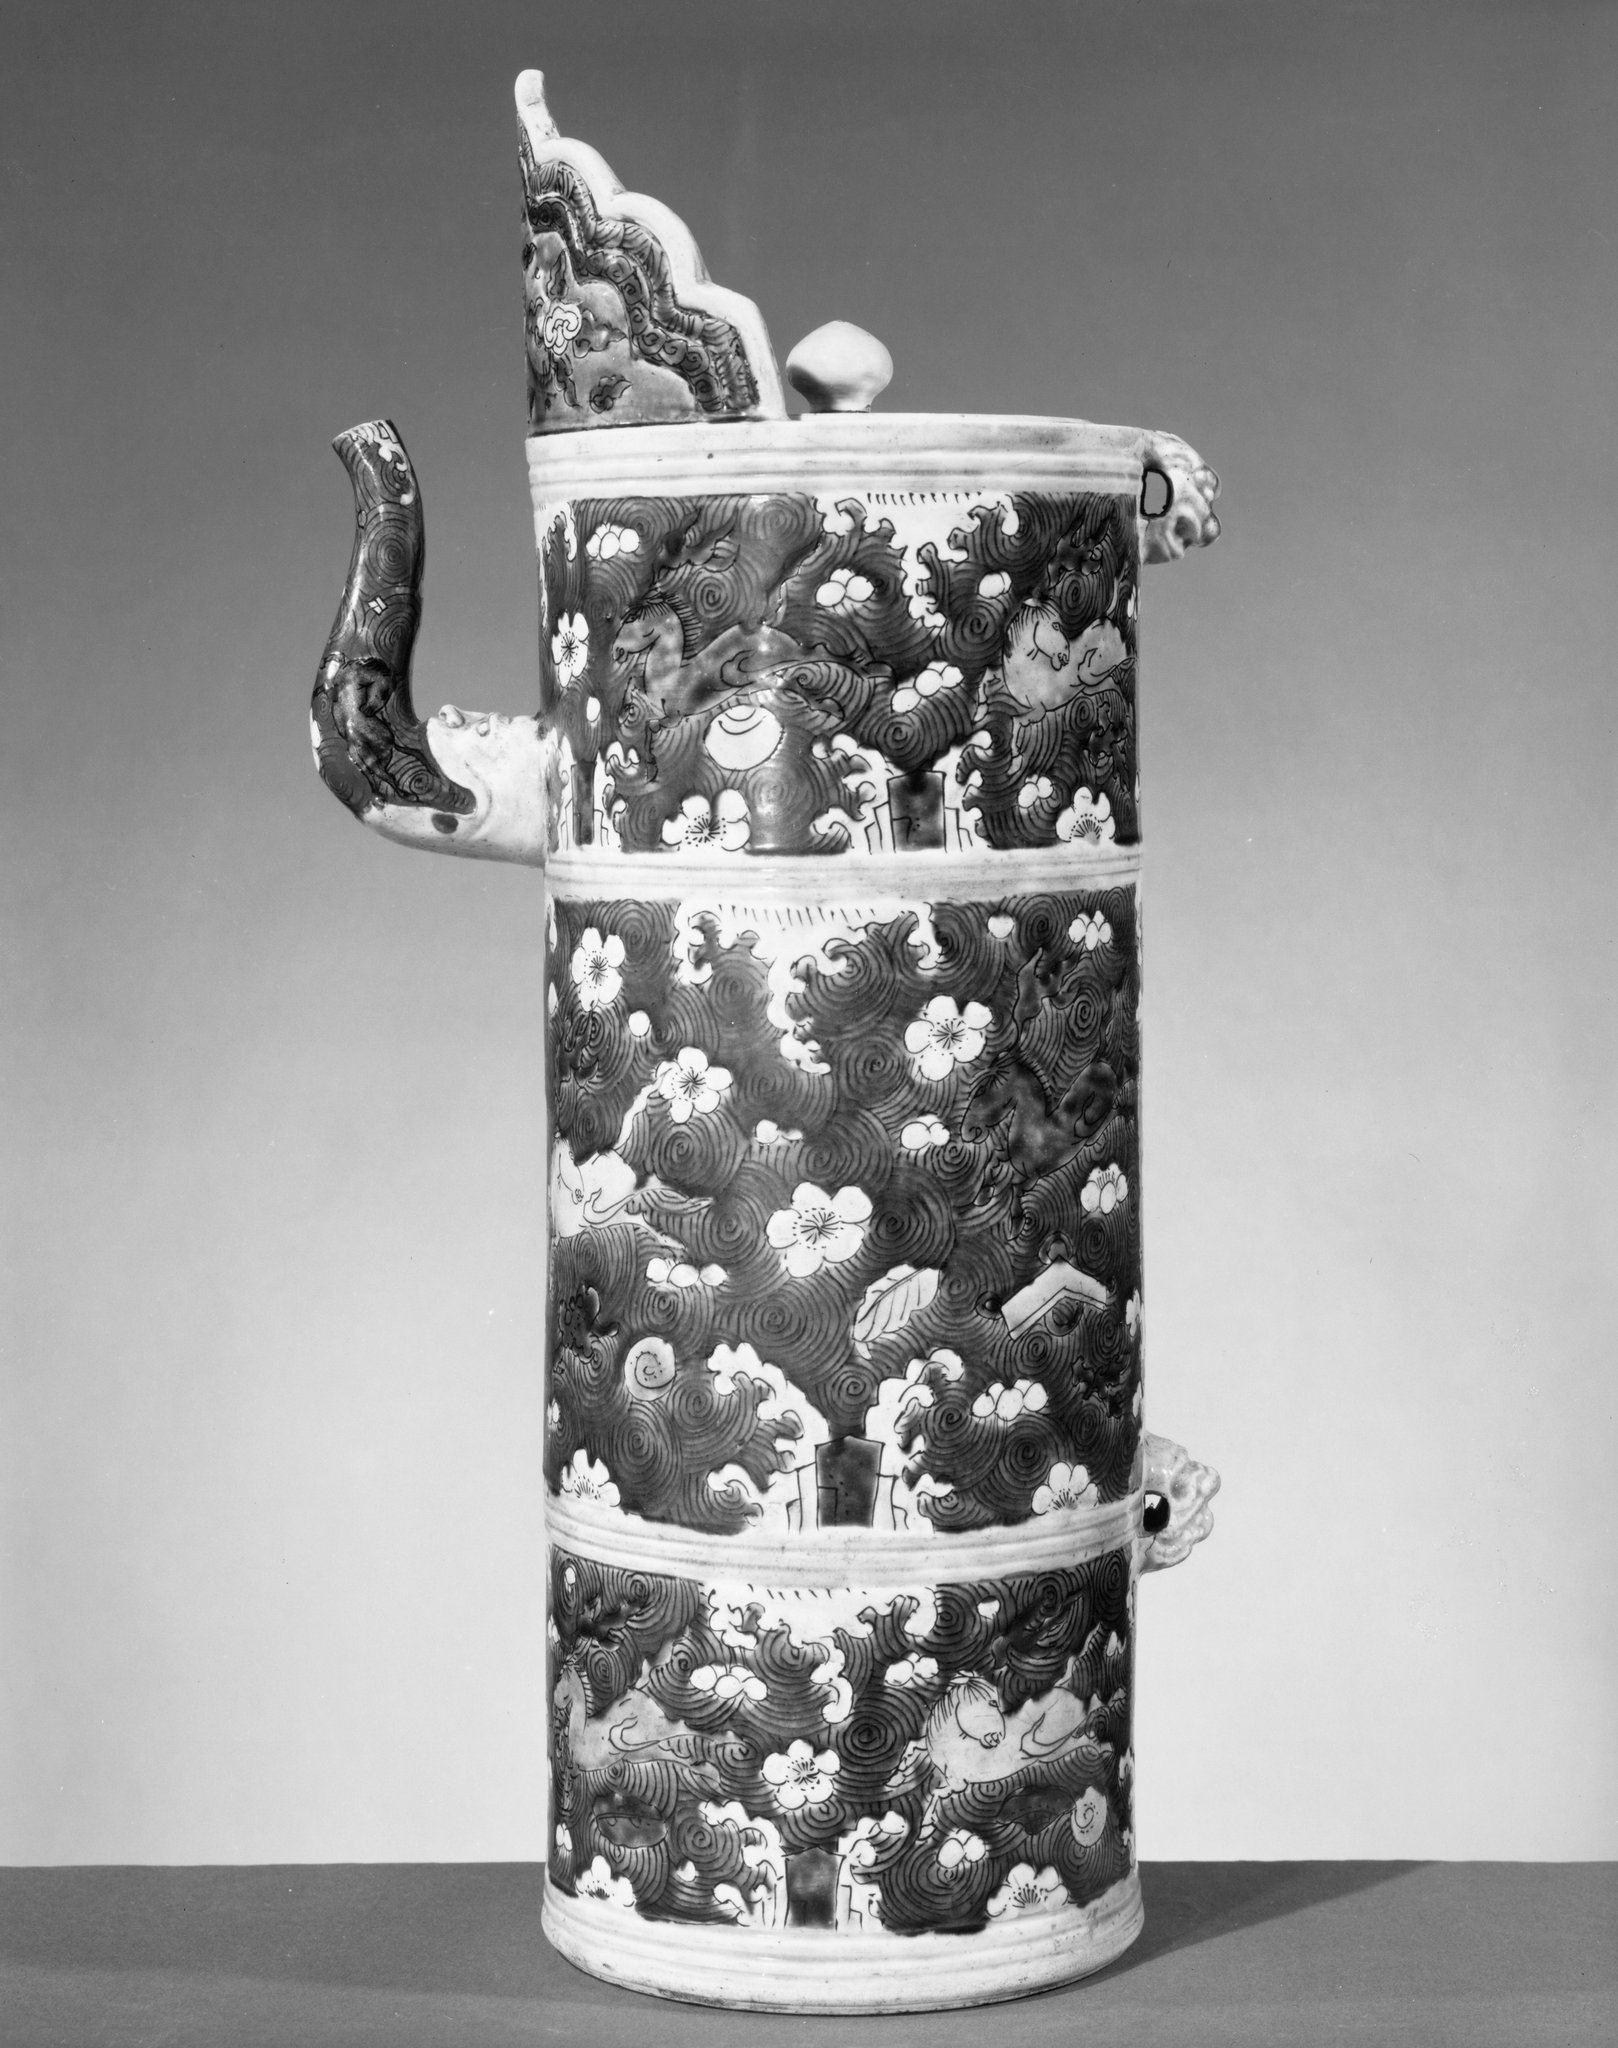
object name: ewer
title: Covered Ewer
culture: chinese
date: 1667-1733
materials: biscuit, enamel, porcelain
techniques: painting